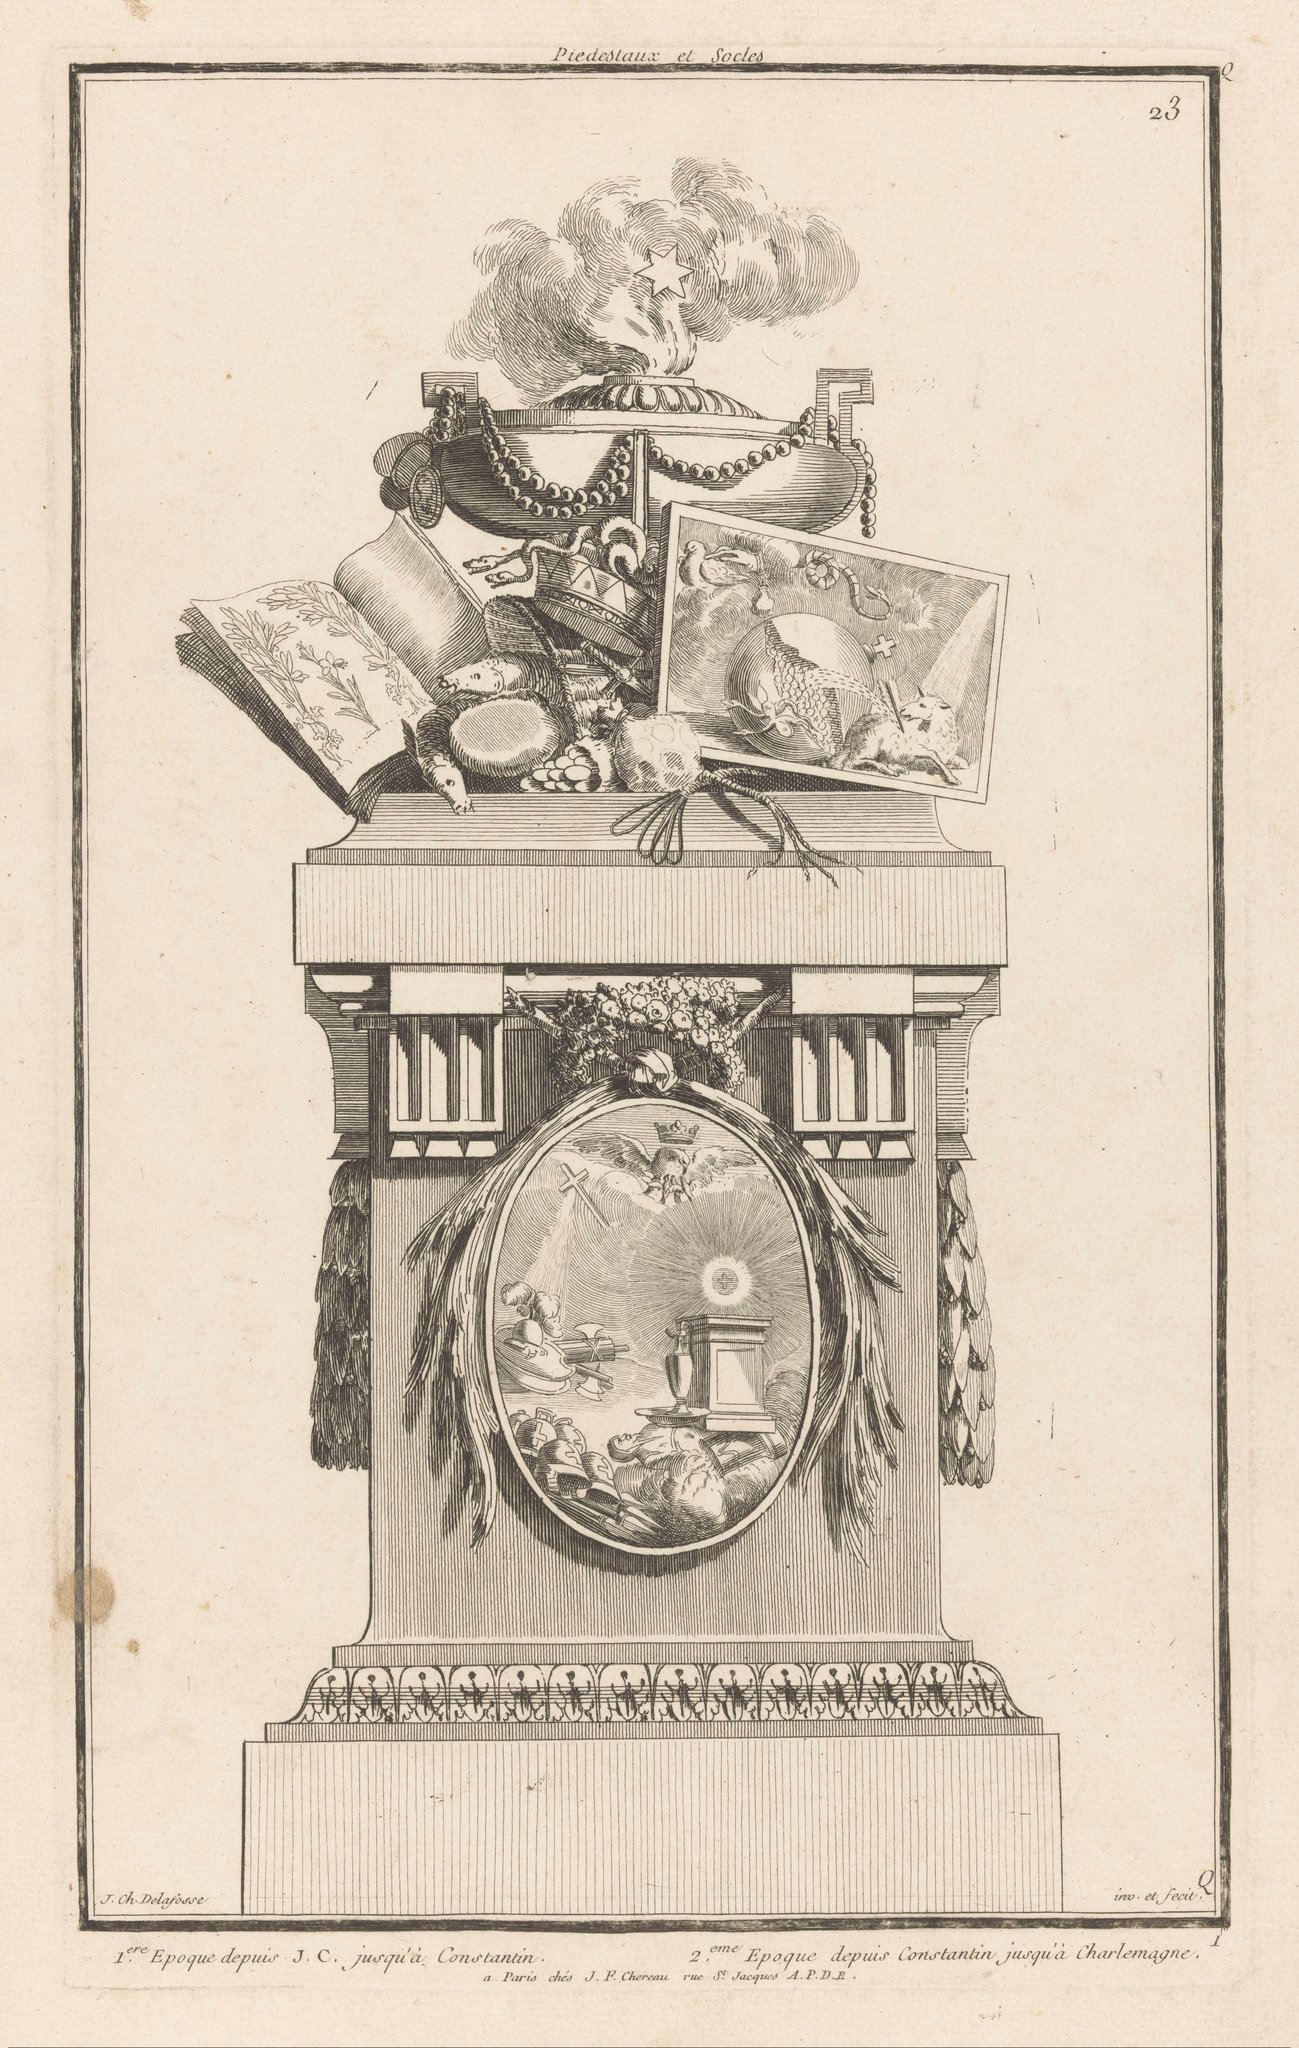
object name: ornament print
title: Nouvelle Iconologie Historique Ou Attributs Hierogliphyques (...)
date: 1768-1771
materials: paper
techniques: engraving, etching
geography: paris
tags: charlemagne (holy roman emperor), christ, pedestal of a piece of sculpture (perhaps in the form of a herm)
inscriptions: collector's mark: Lugt 2760, collector's mark: Lugt 2228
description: Een voetstuk met een ovaal medaillon met helmen, wapens, een voetstuk, een kruis en een adelaar met een kroon. Op het voetstuk liggen een boek, vissen, slangen, een kroon, een rookvat en een lijst met een globe en een lam. Prentnummer 23.